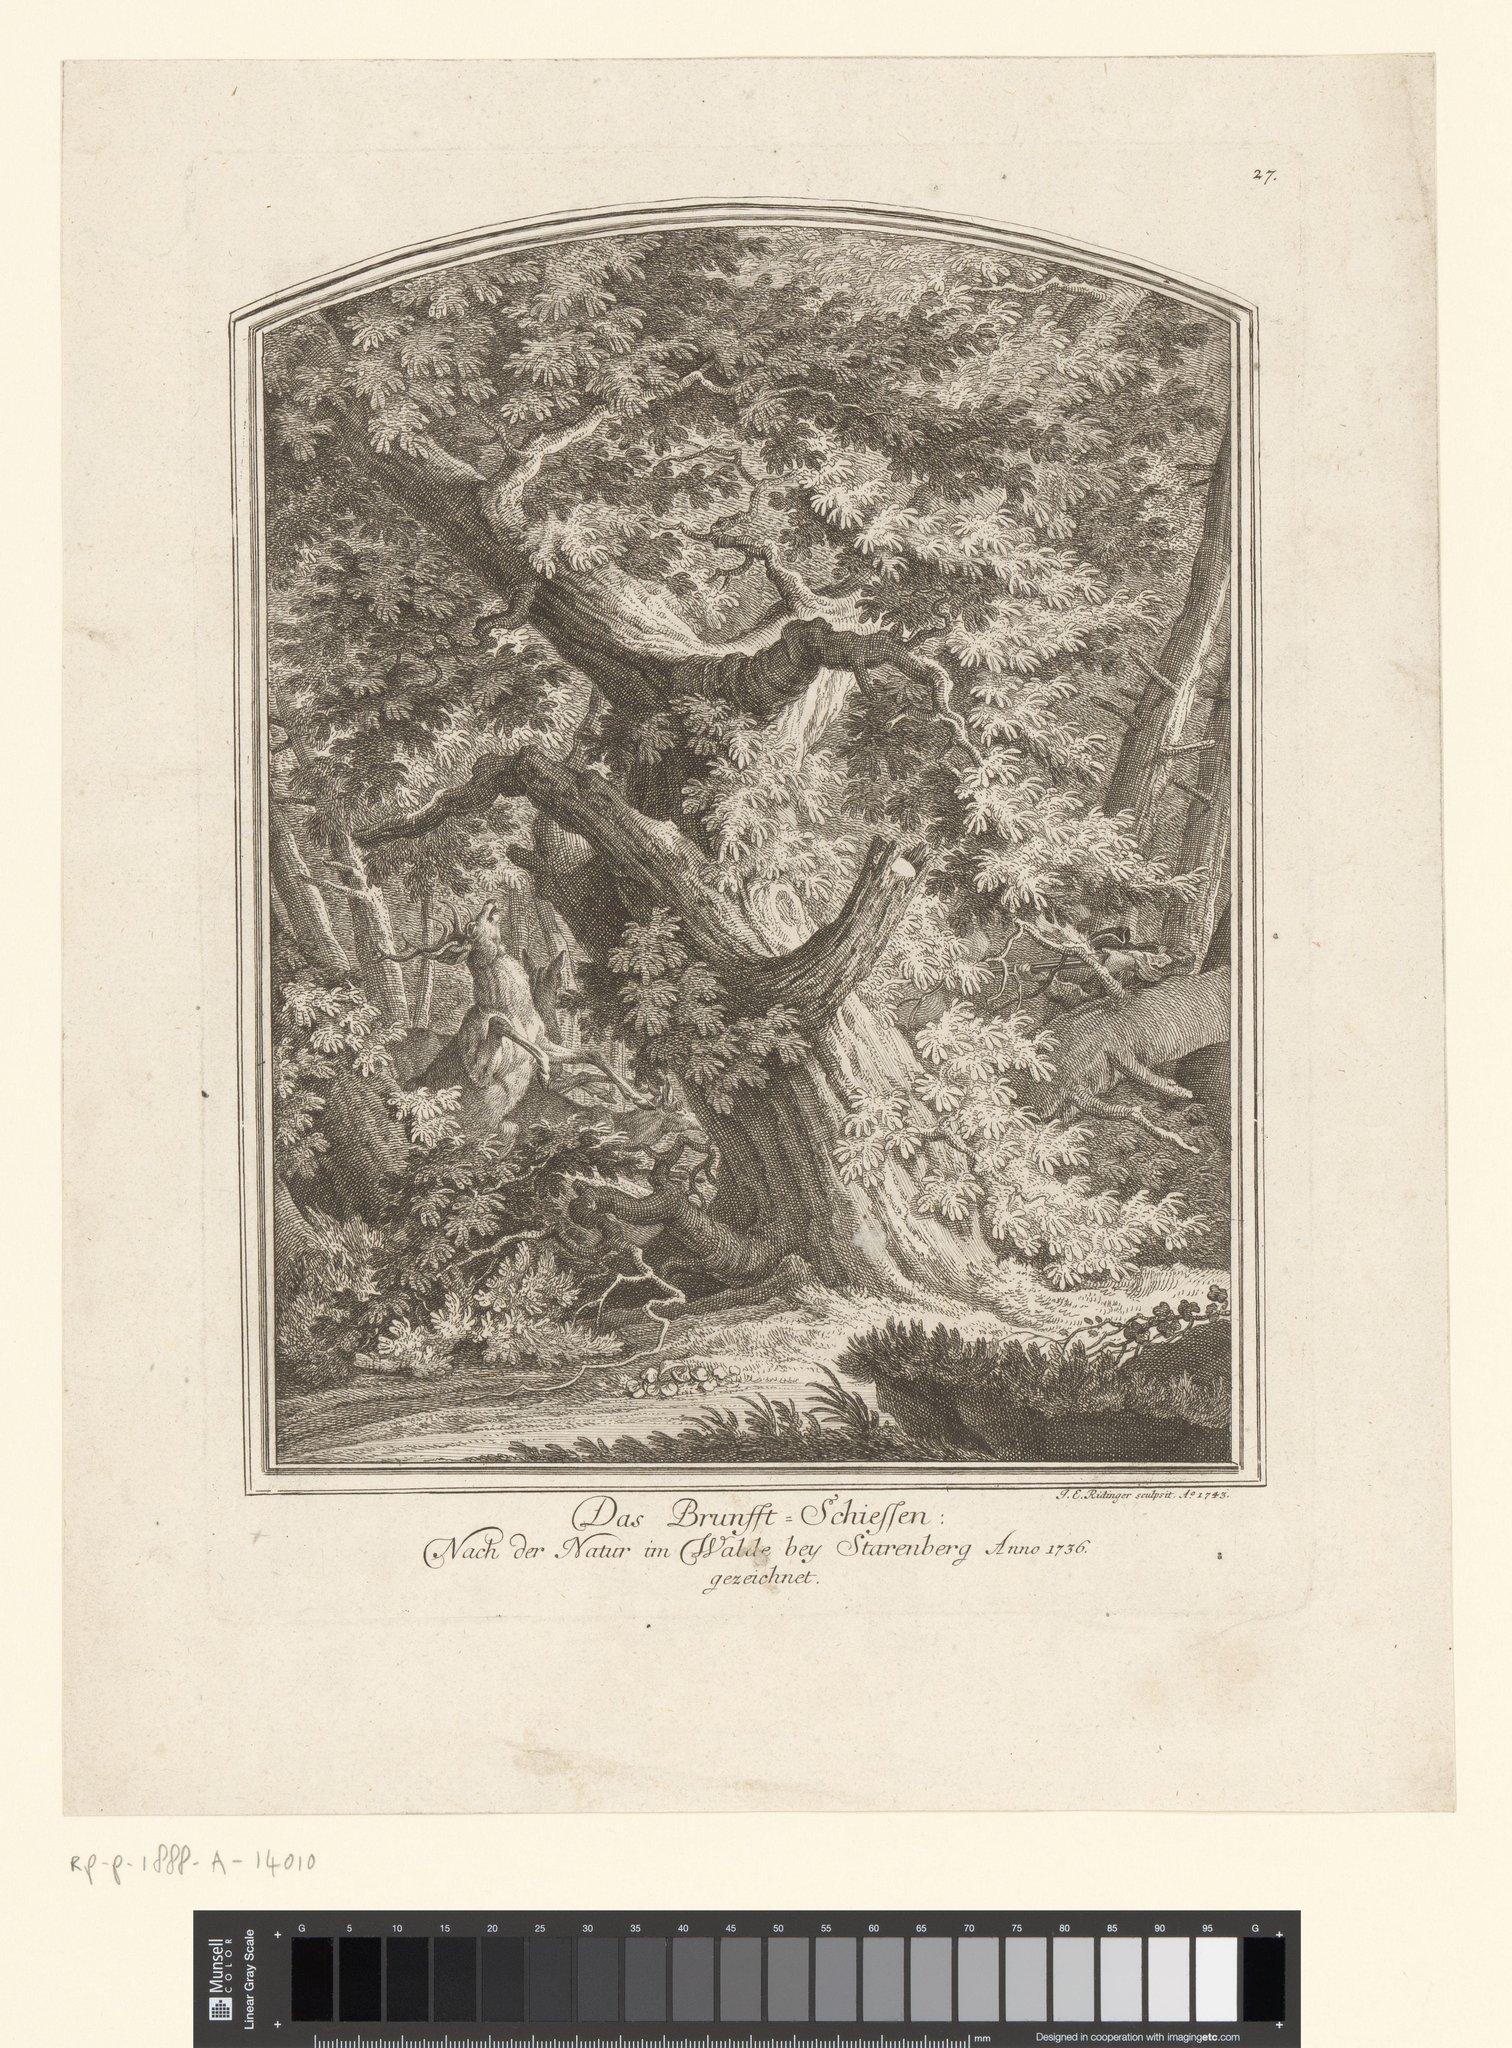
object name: print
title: De 100 meest wonderlijke herten en andere dieren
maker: johann elias ridinger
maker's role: draughtsman, painter, print maker, publisher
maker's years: 1698-1767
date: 1745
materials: paper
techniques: etching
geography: augsburg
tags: stag-hunting, forest, wood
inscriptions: collector's mark: Lugt 2228